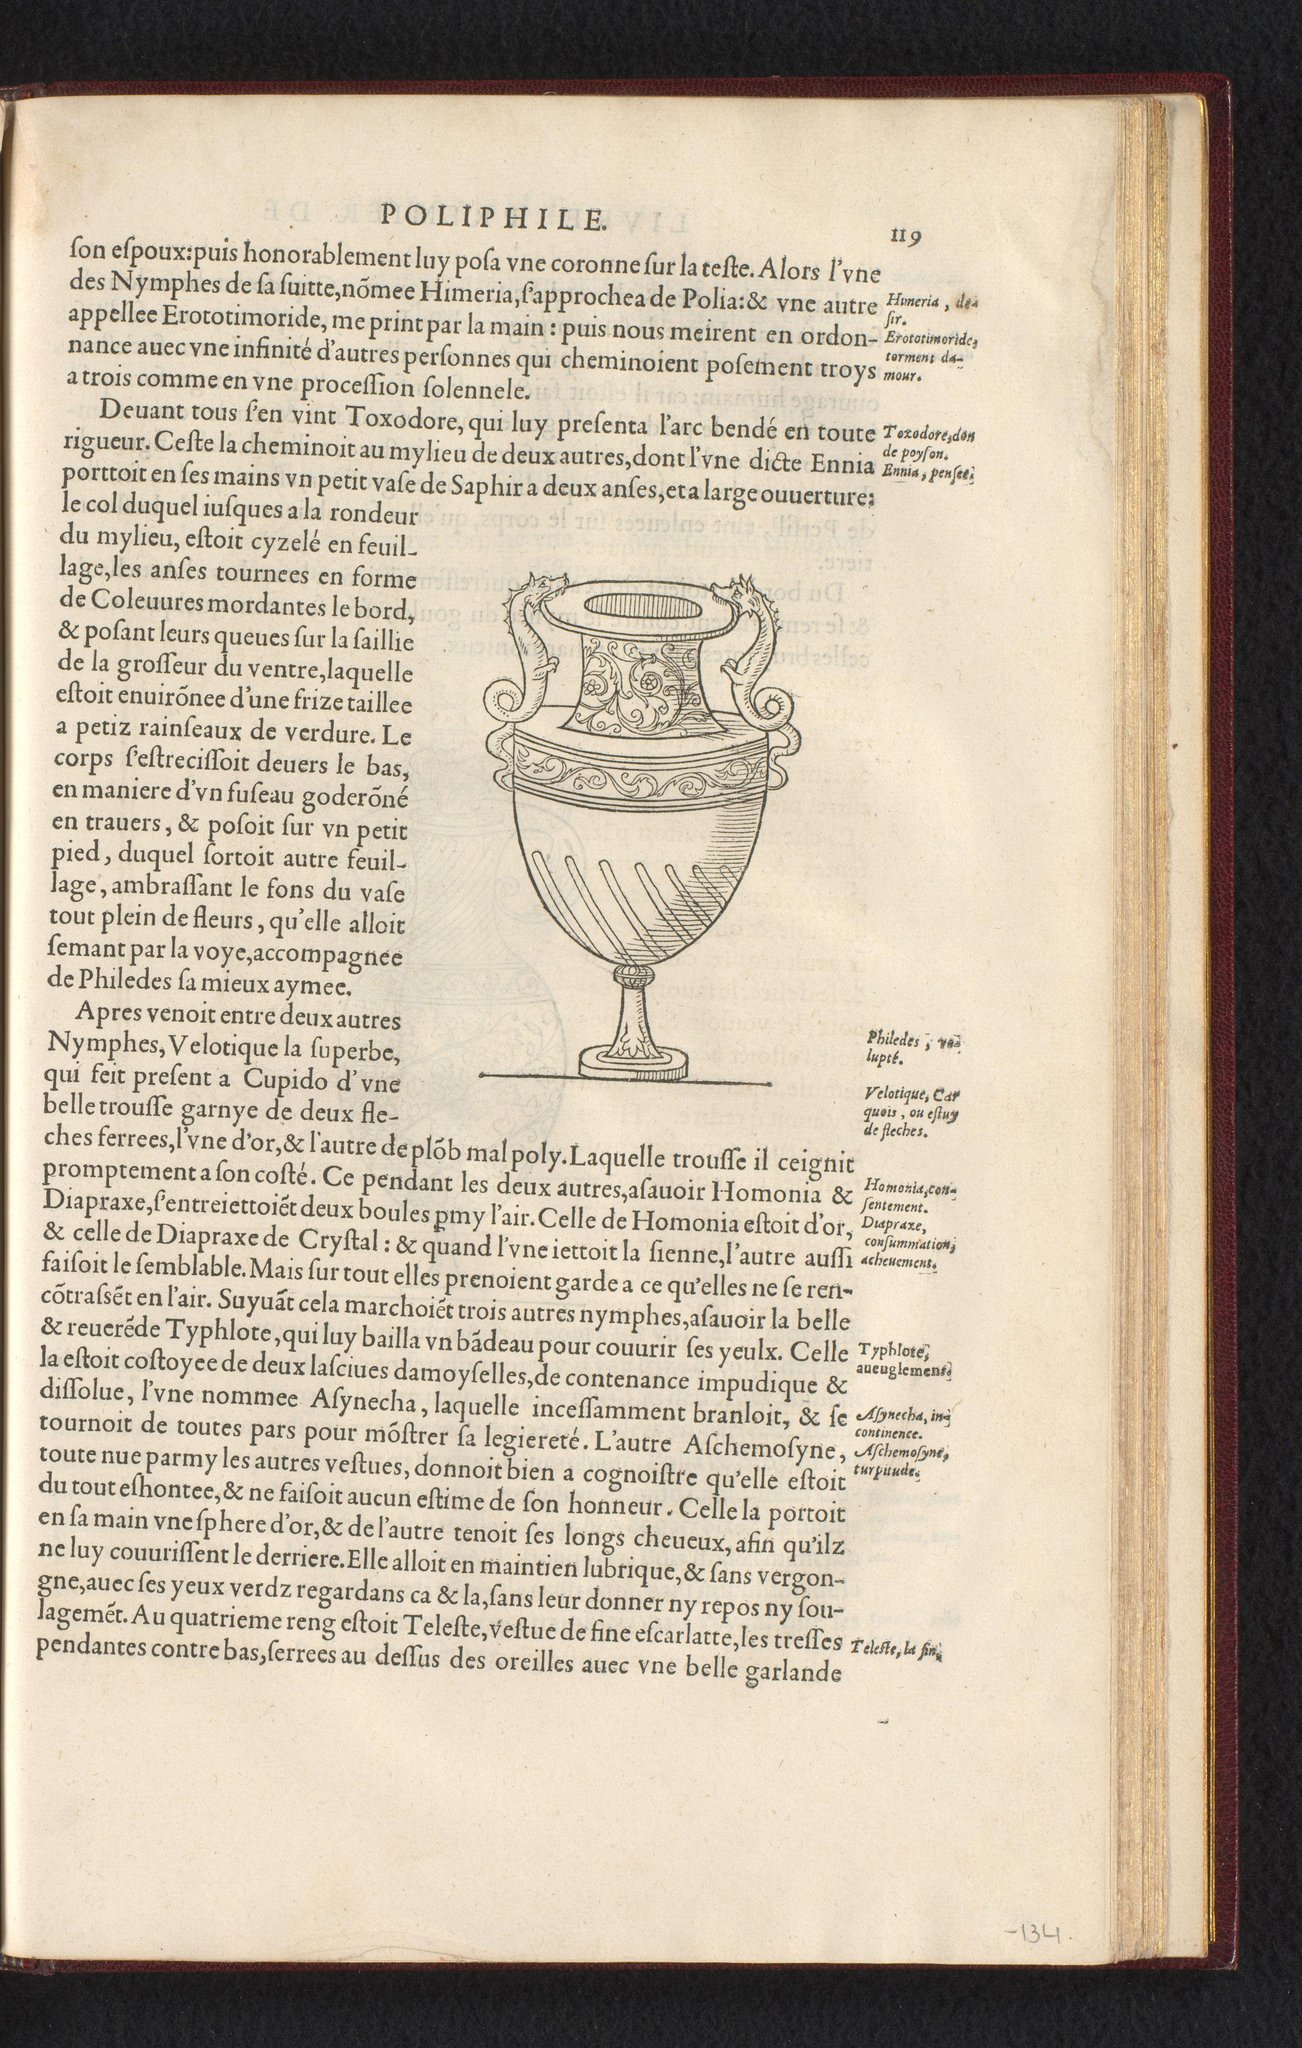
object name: print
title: Vaas met draken als oren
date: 1546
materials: paper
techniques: letterpress printing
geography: paris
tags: vase ~ ornament, (scenes from) specific works of literature: colonna, hypnerotomachia poliphili, dragon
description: Prent uit: Colonna, Francesco. Hypnerotomachie ou discours du songe de Poliphile, deduisant comme amour le combat a l'occasion de Polia. Parijs: Jacques Kerver, 1546, recto fol. 119.